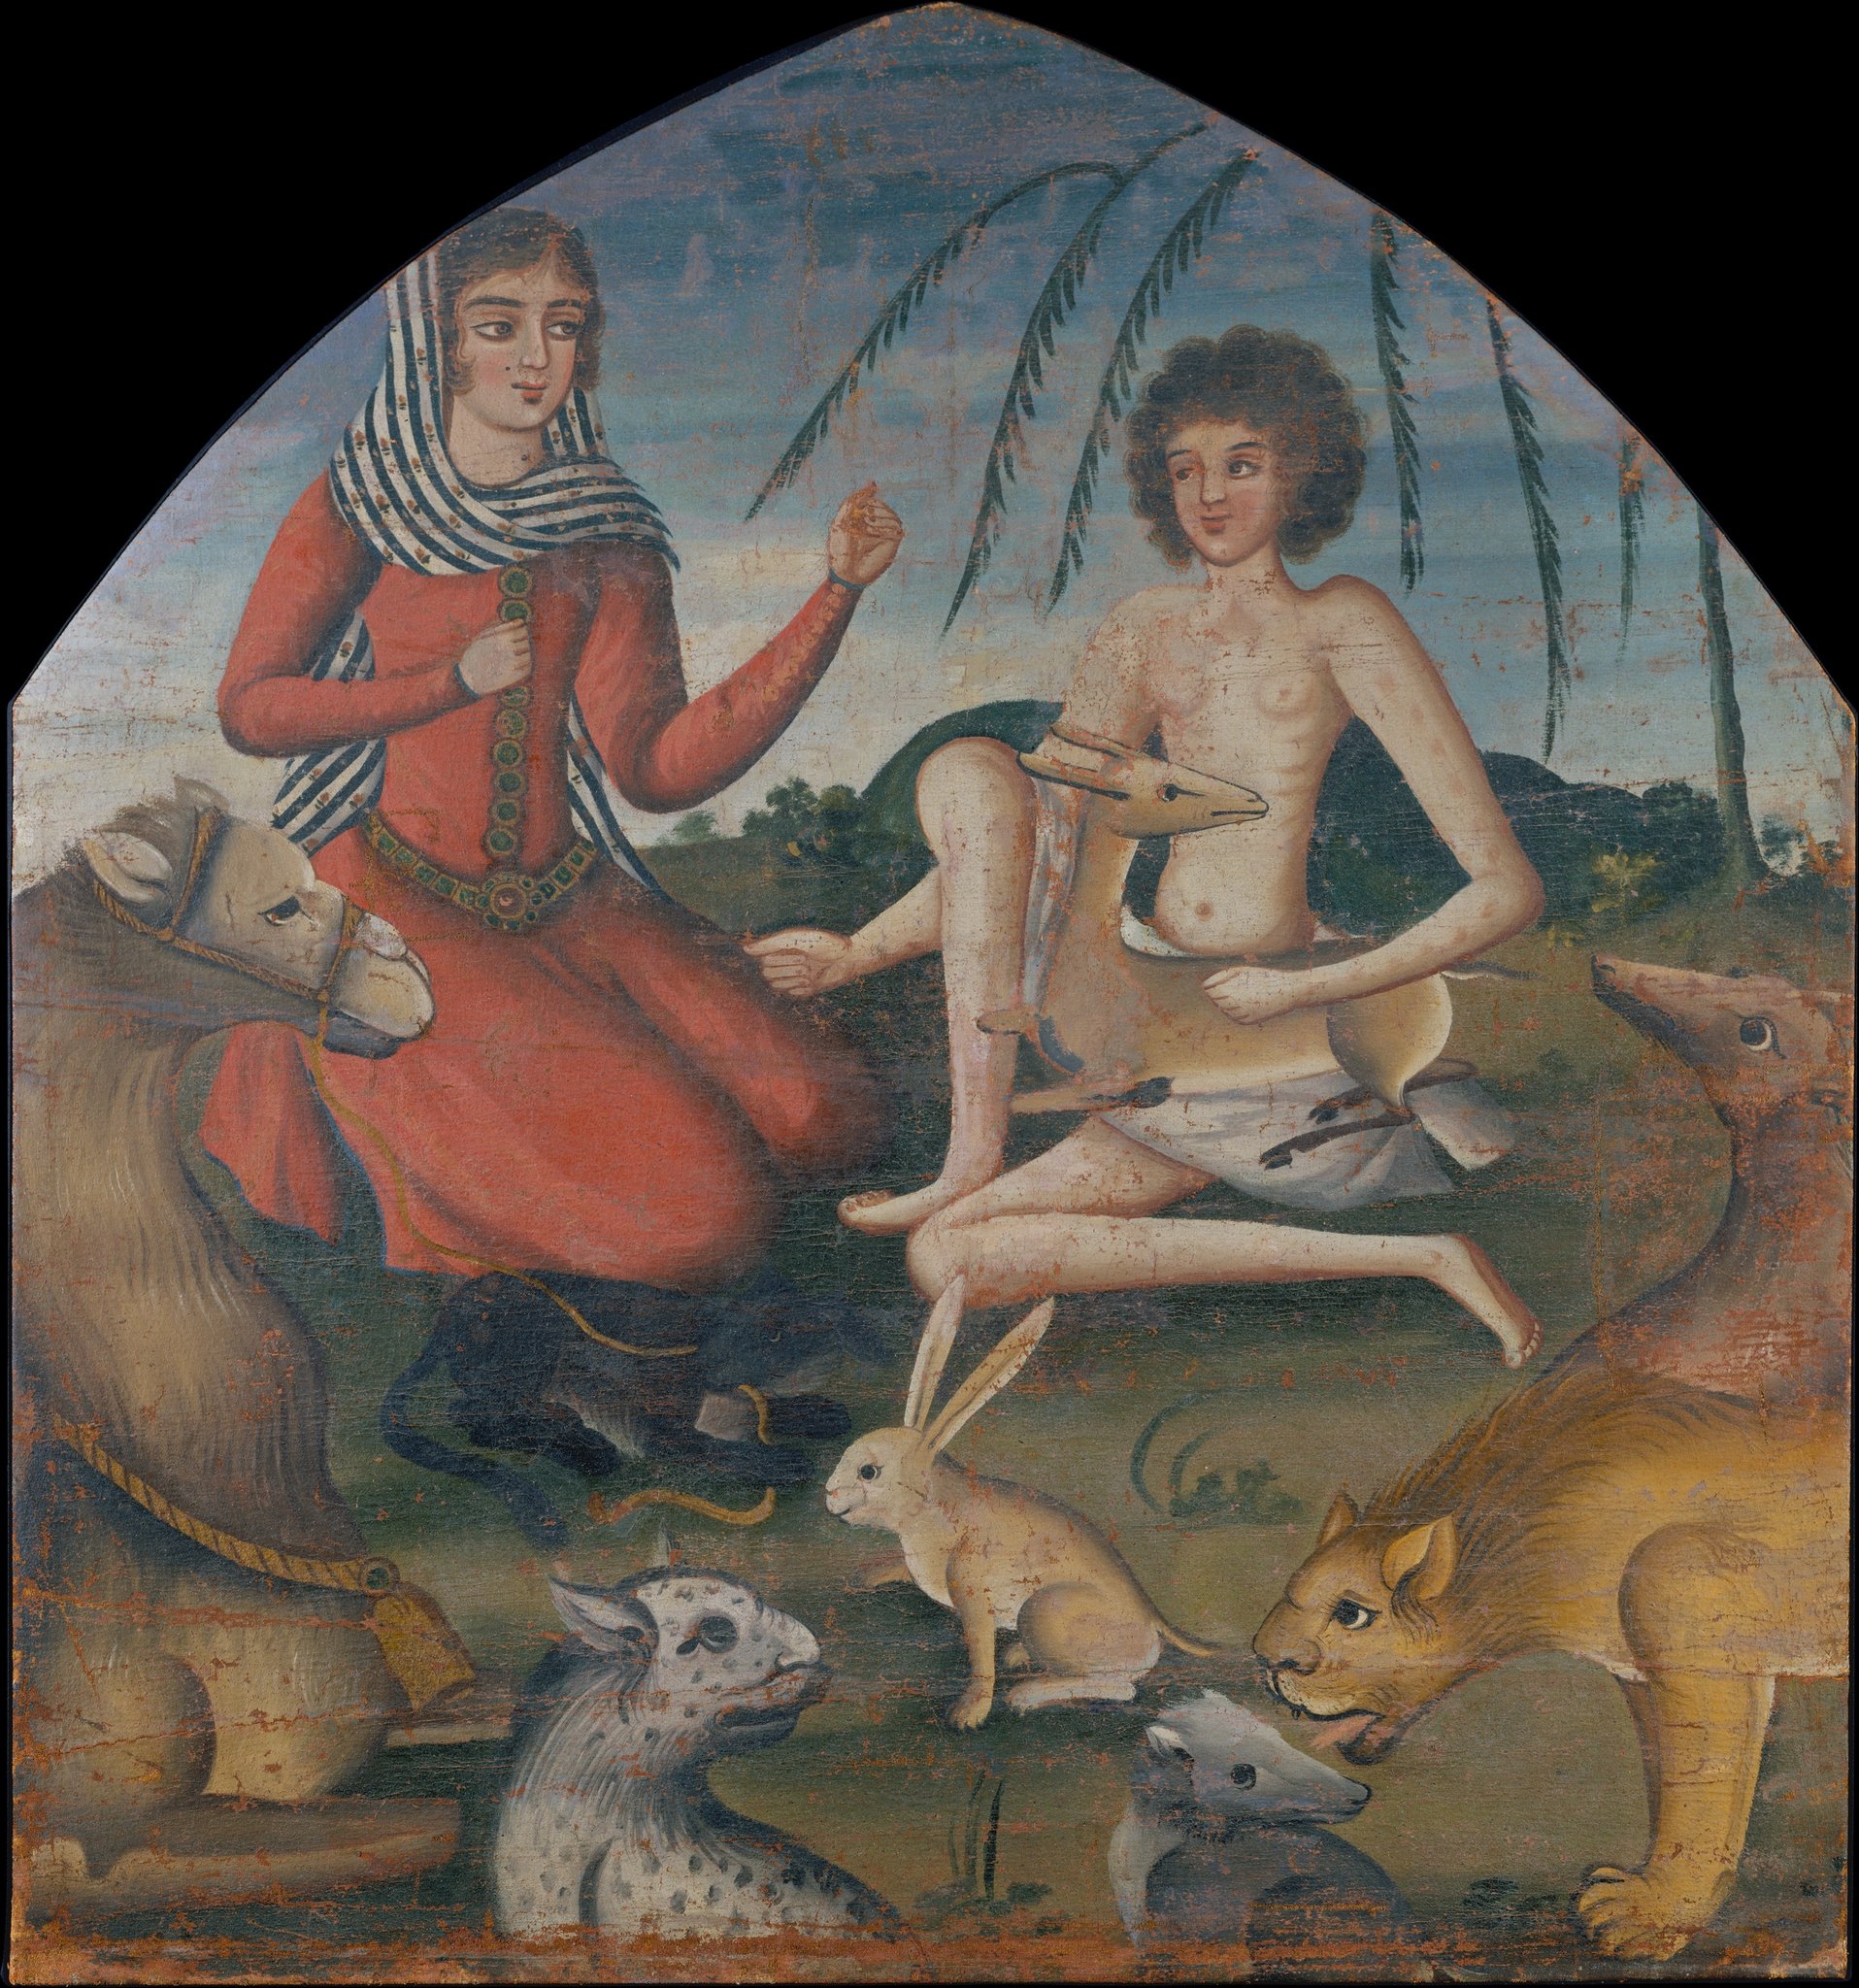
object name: painting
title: Laila and Majnun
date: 1734-1766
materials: canvas, oil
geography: iran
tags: couples,men,women,deer,rabbits